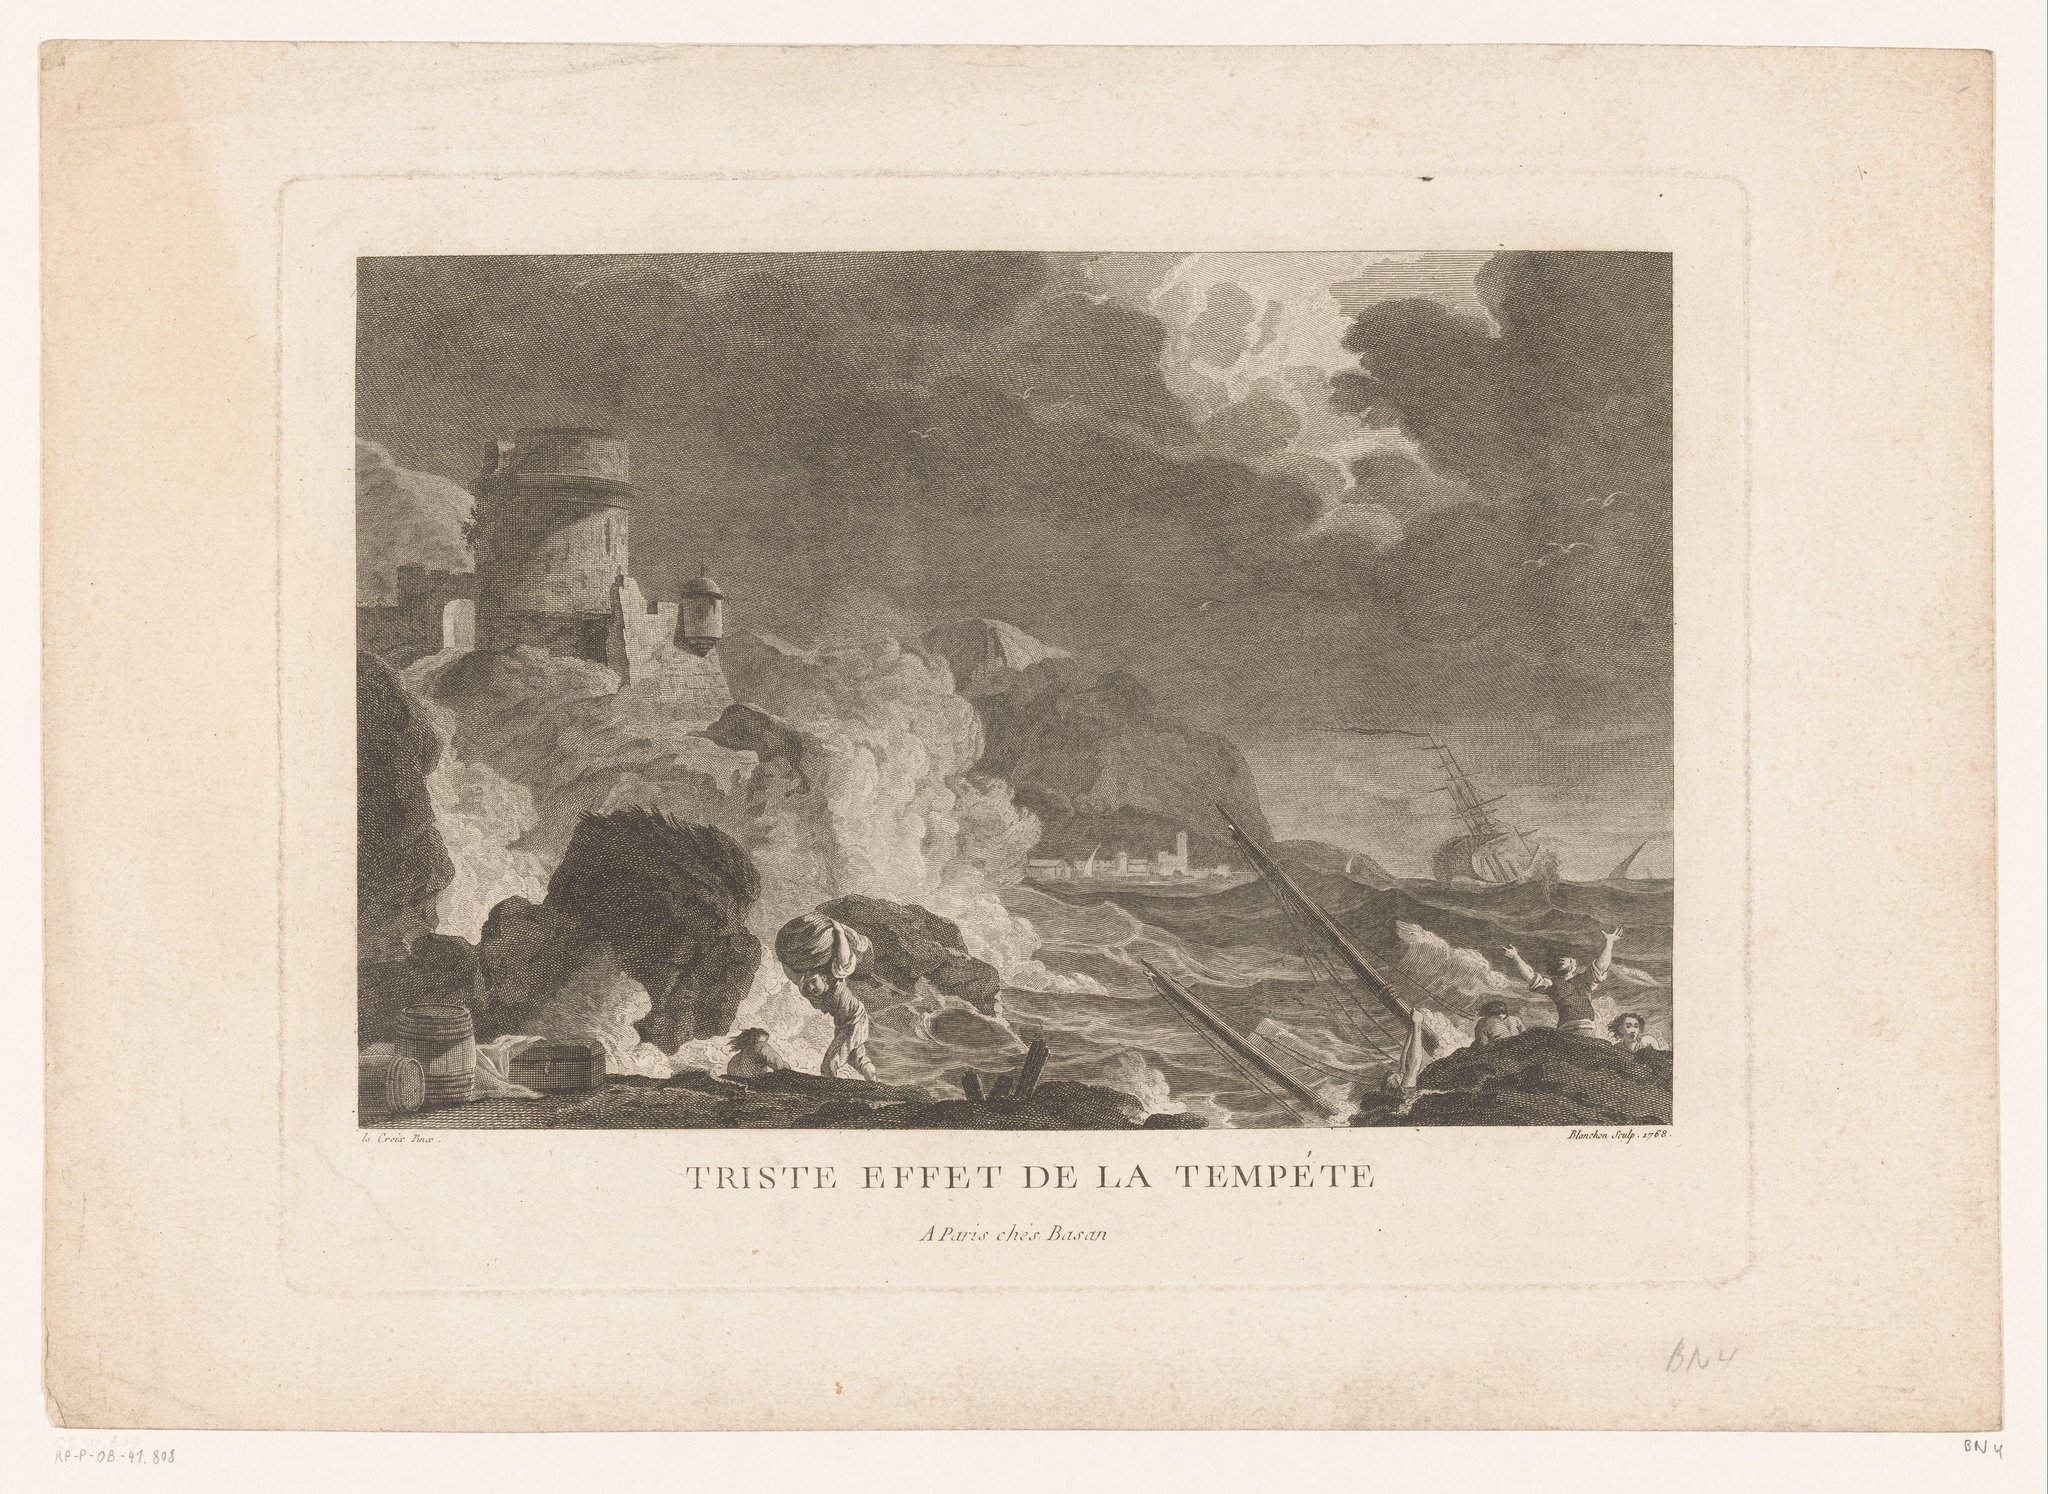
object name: print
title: Storm op zee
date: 1768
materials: paper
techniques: engraving, etching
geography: france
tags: ships (in general) - cc - more than one ship, storm at sea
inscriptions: collector's mark: Lugt 2228